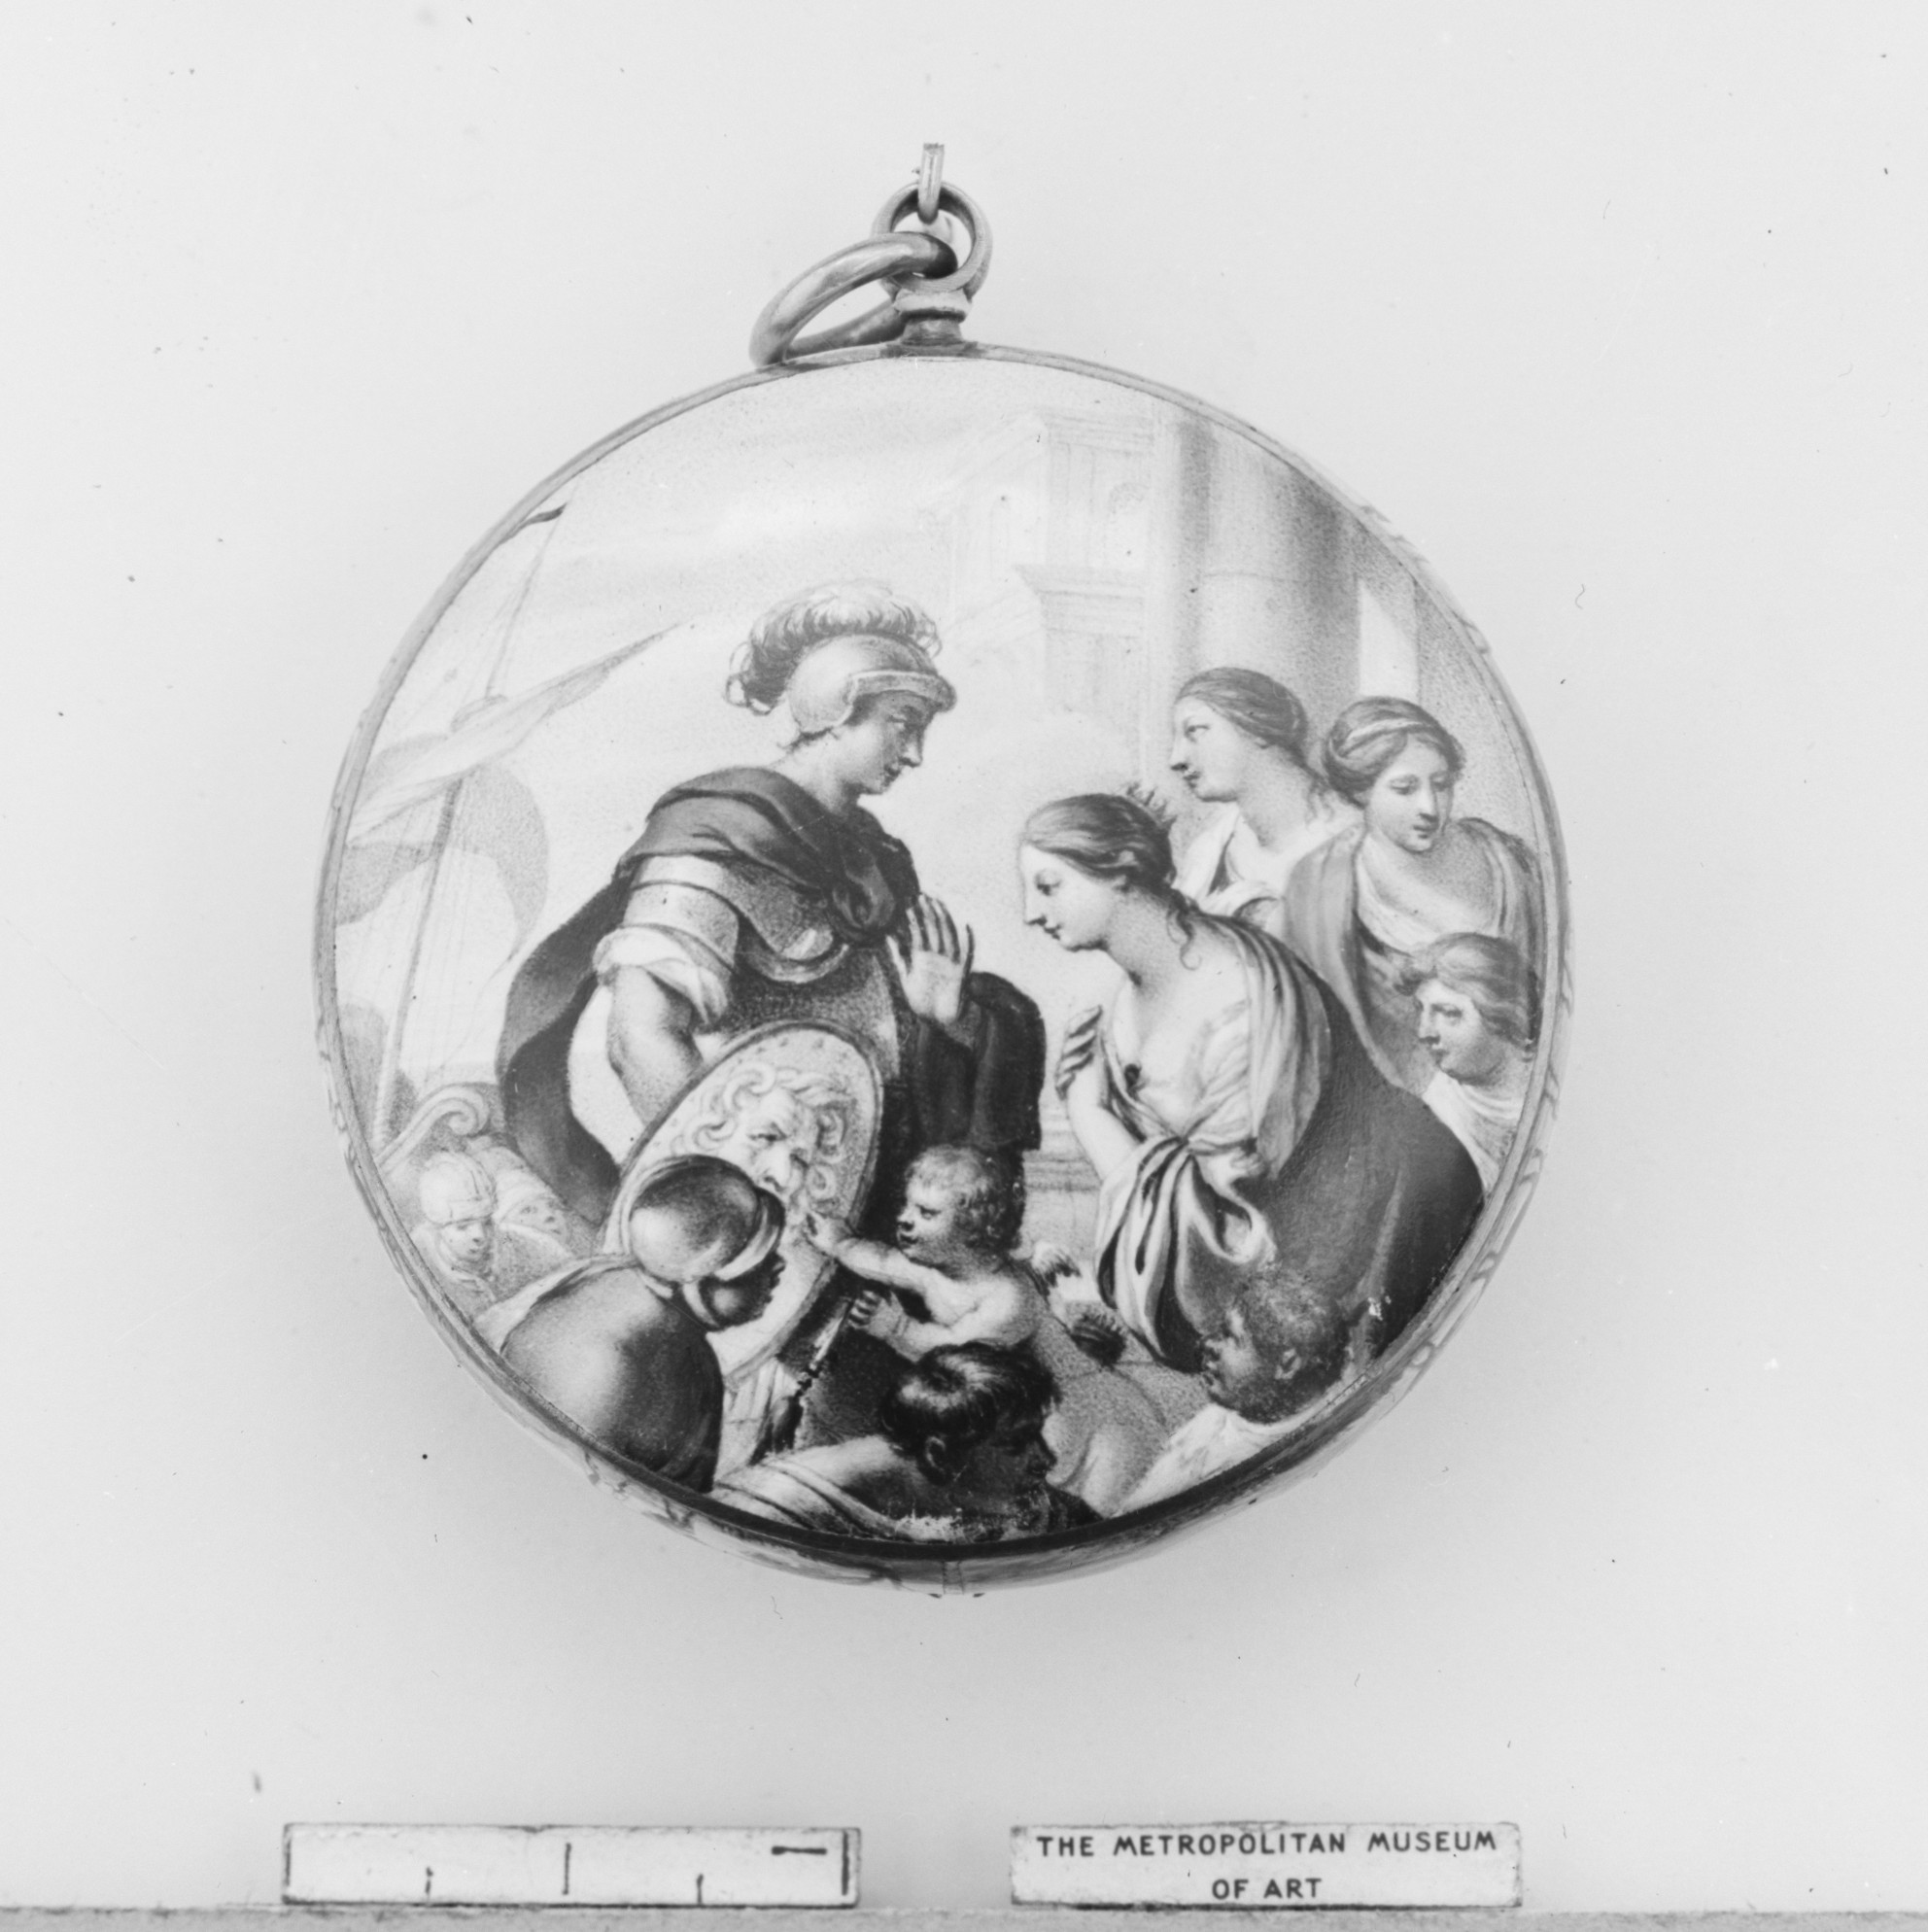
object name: watch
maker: g. gamot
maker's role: maker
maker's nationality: french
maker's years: 1641-1651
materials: gold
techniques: enamel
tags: children,men,women